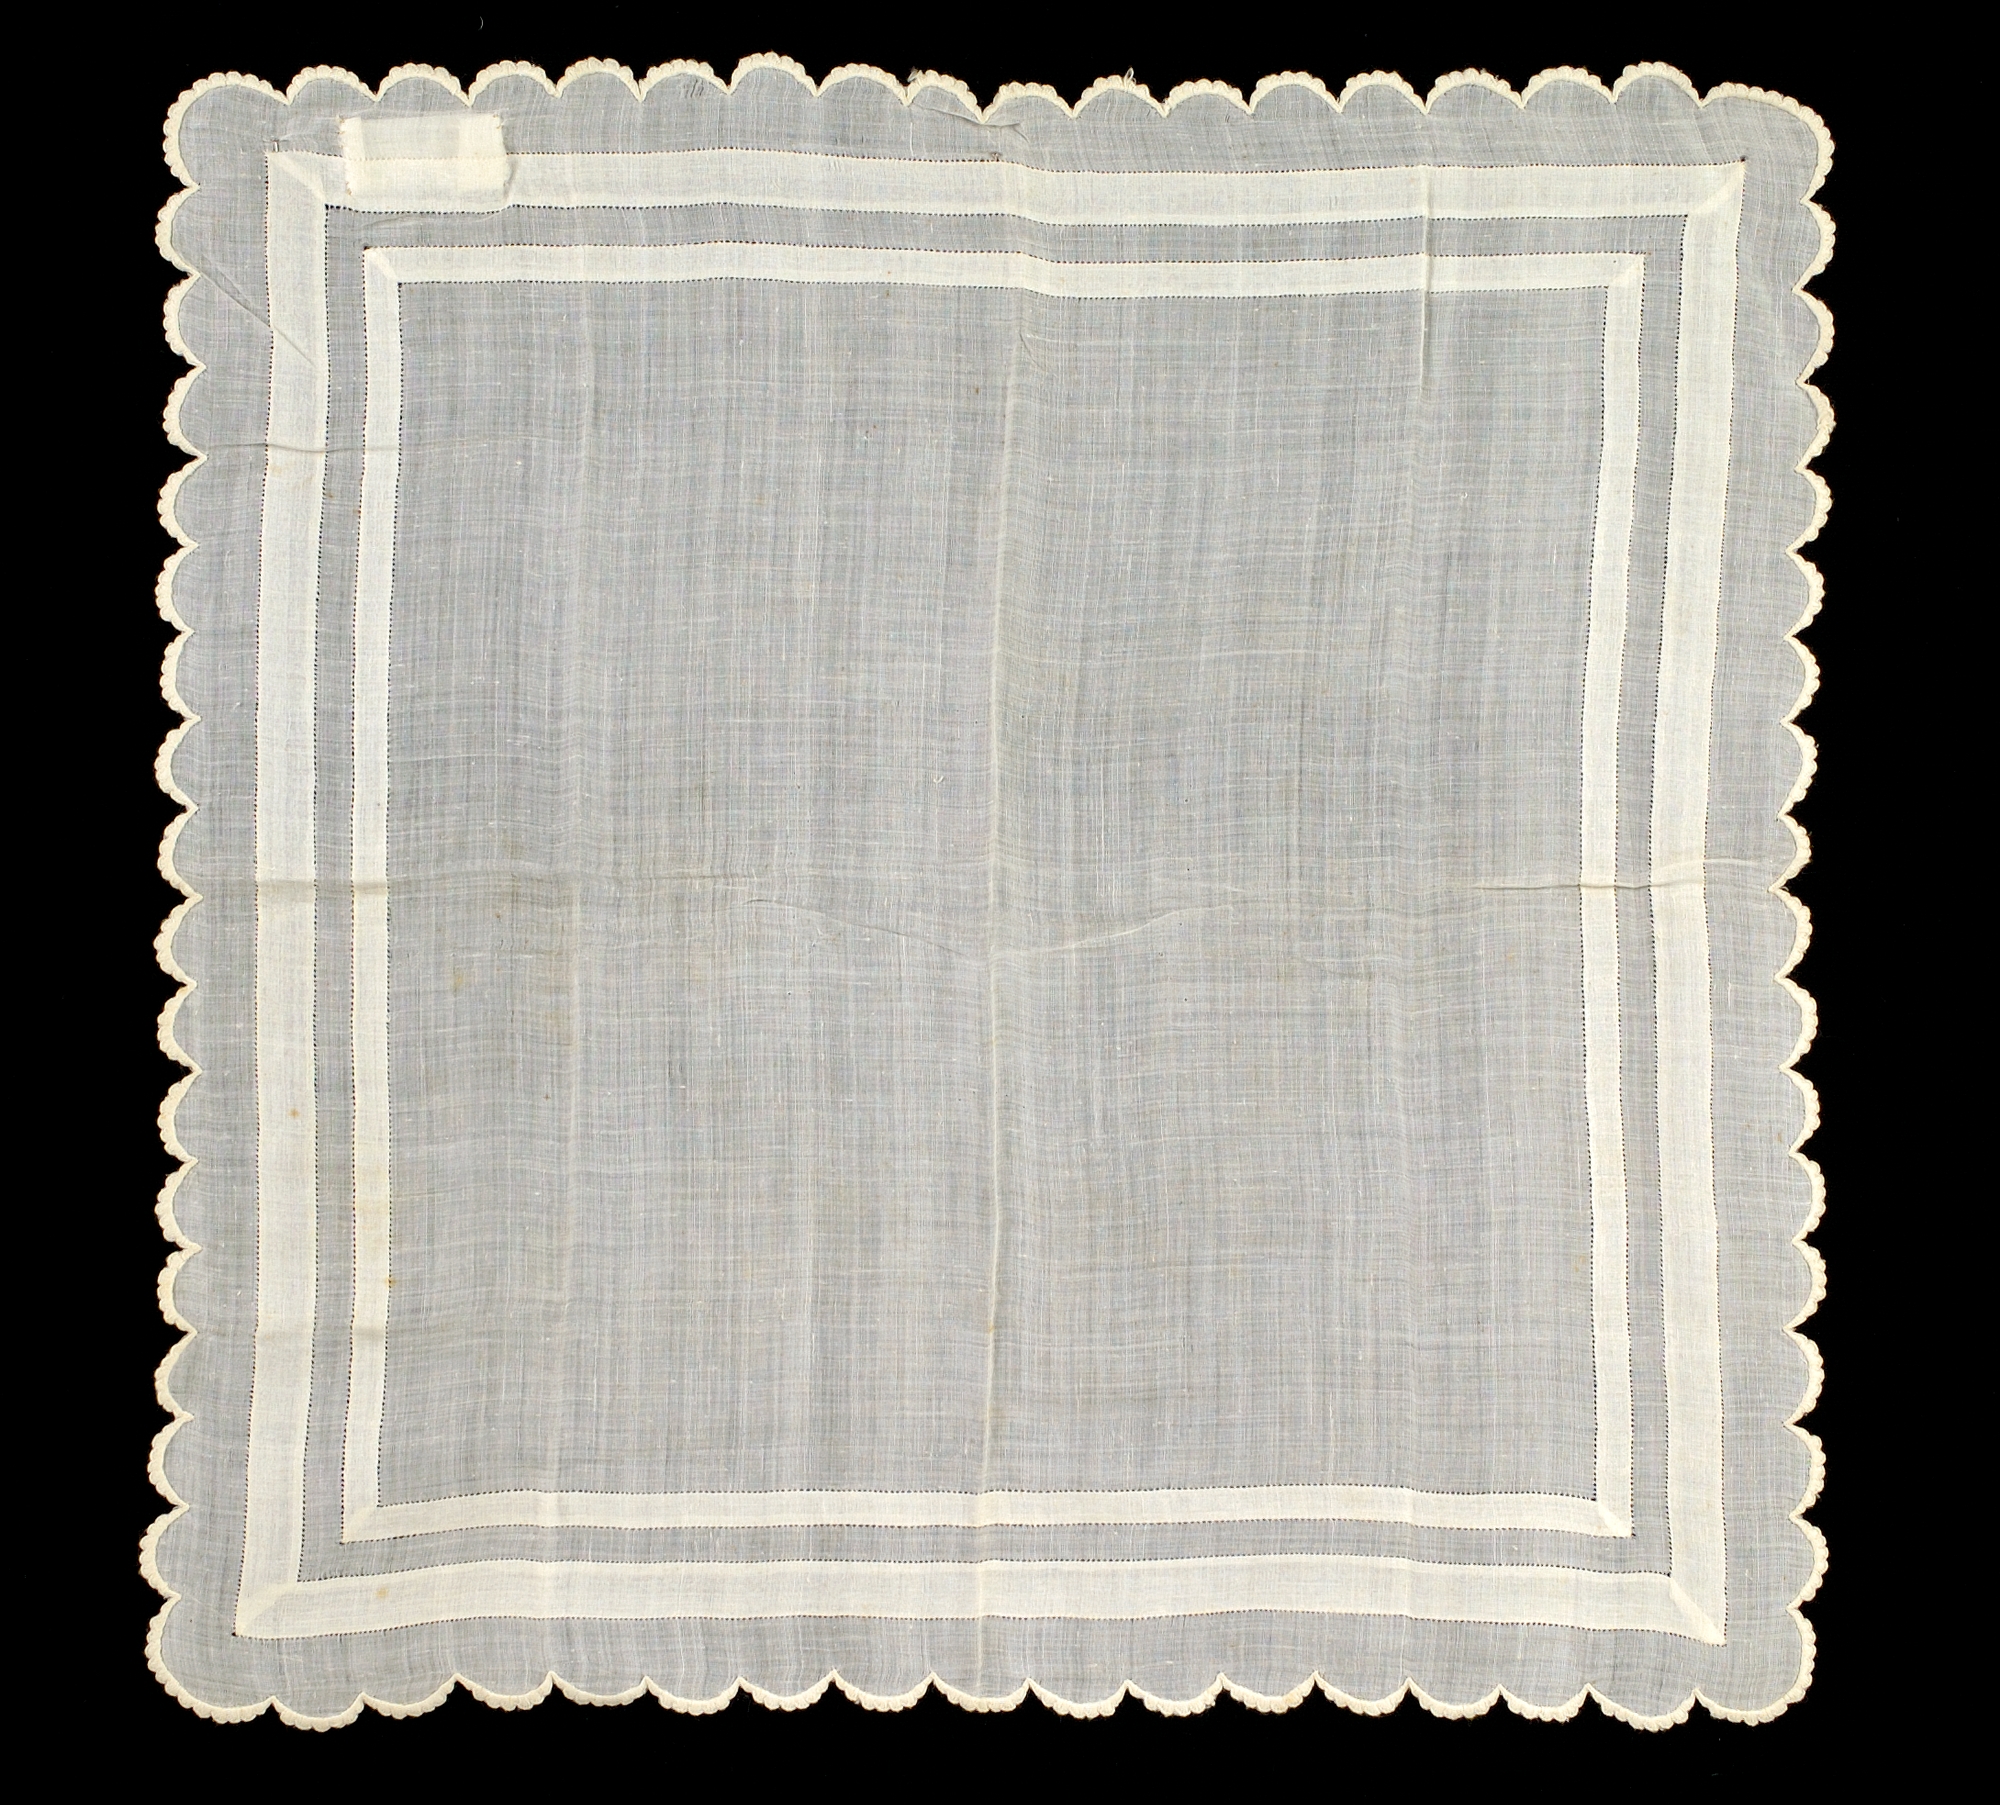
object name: handkerchief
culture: american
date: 1840-1860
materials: linen